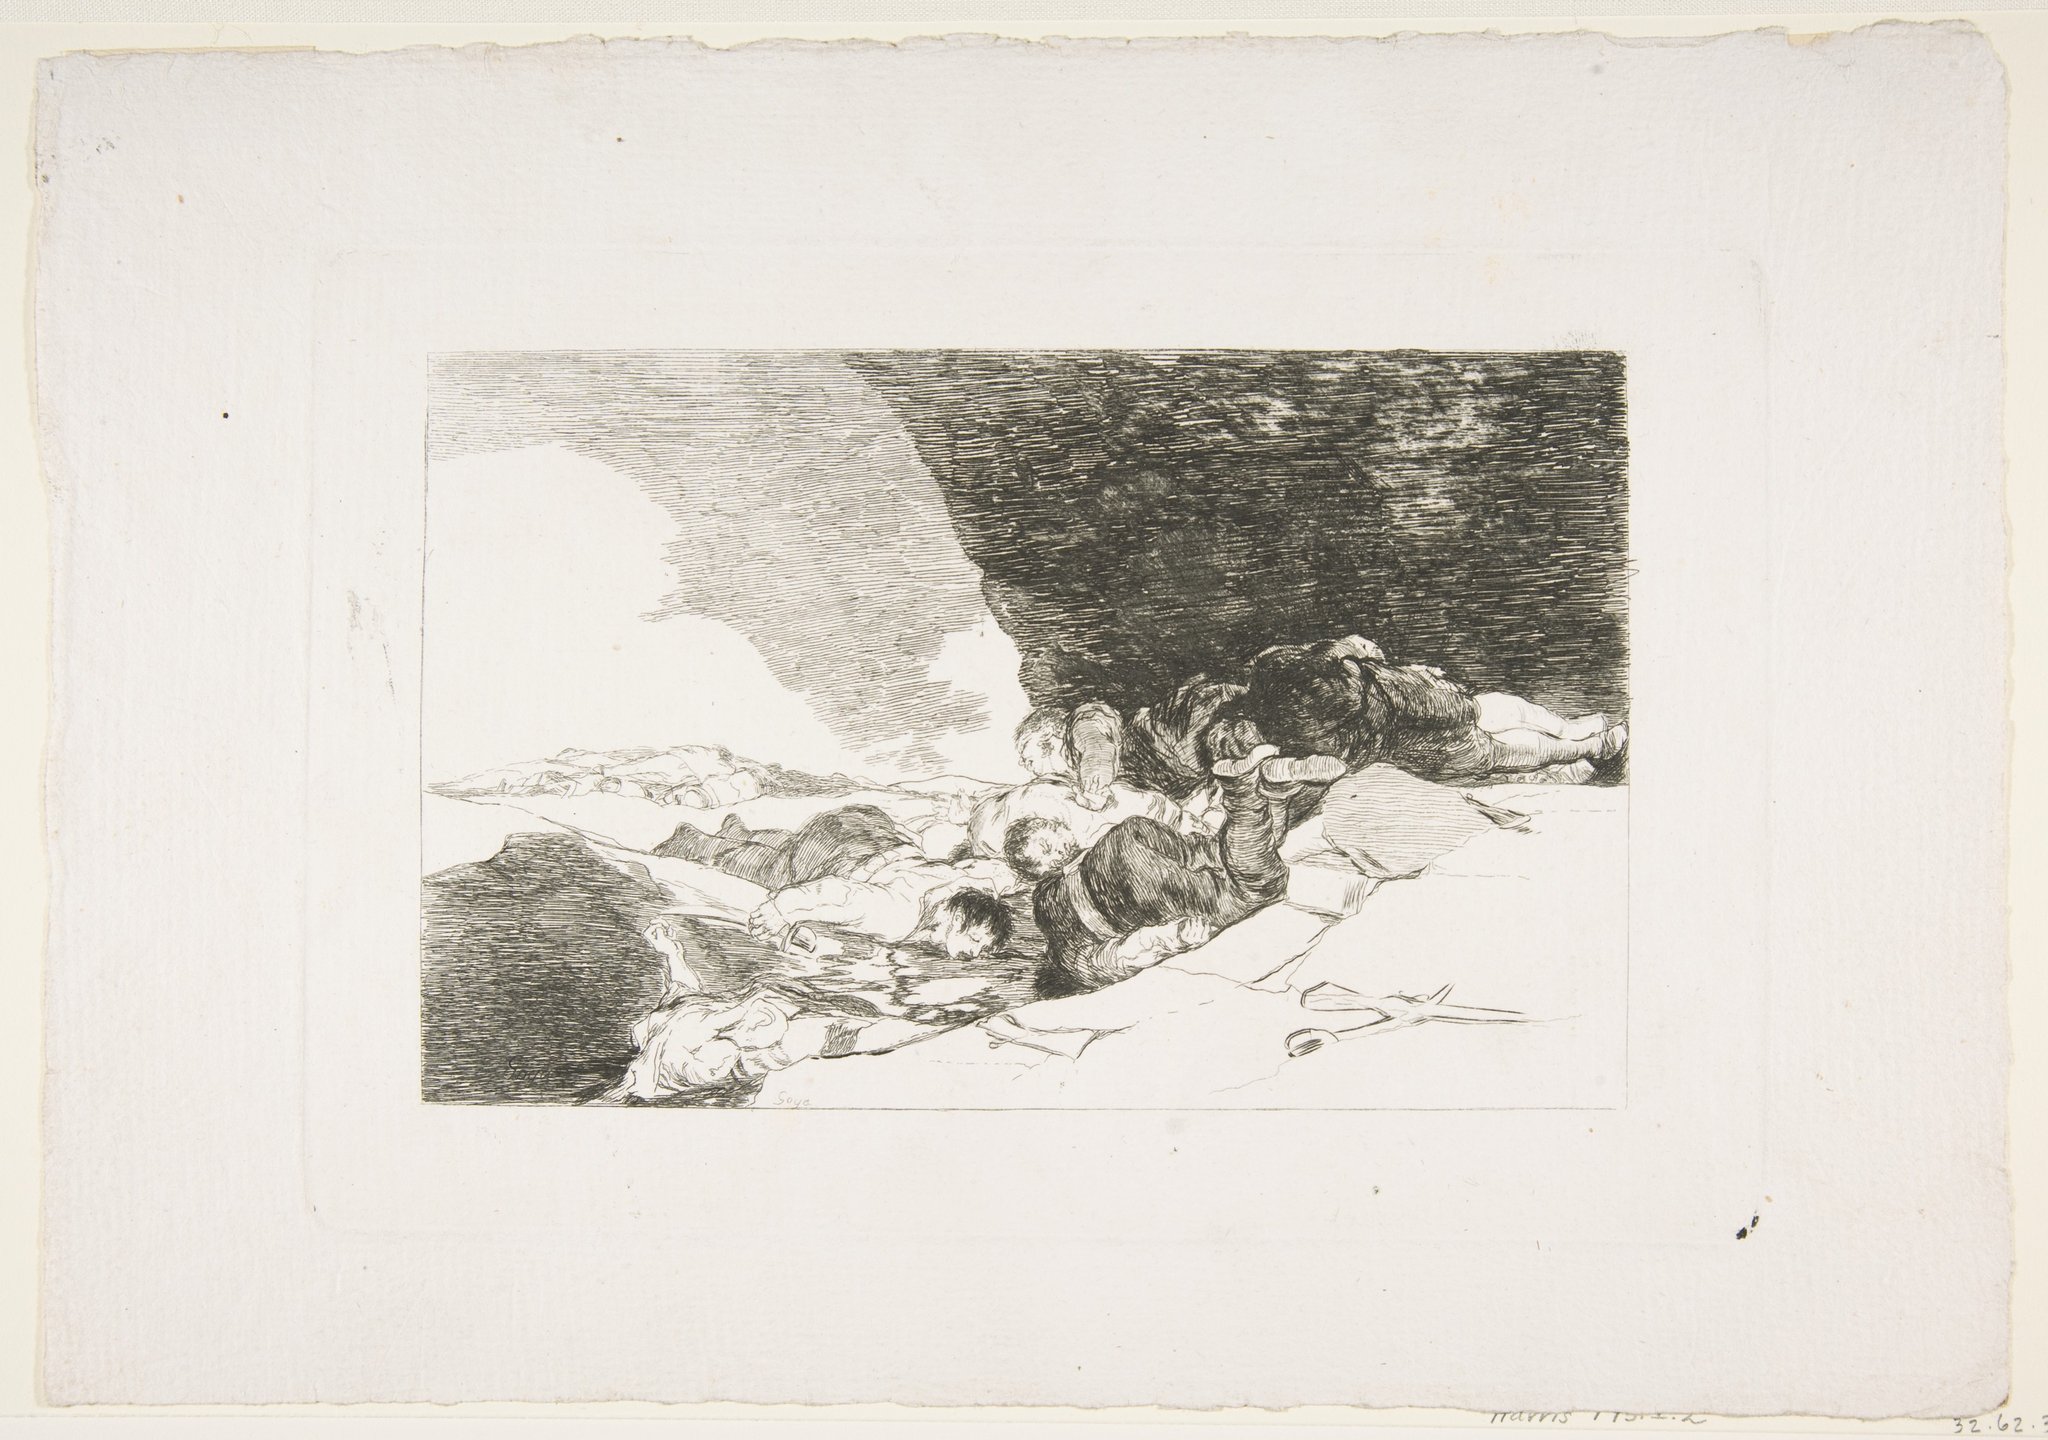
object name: print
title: Plate 23 from "The Disasters of War" (Los Desastres de la Guerra): 'The Same Elsewhere' (Lo mismo en otras partes)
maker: goya (francisco de goya y lucientes)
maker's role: artist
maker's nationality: spanish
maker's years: 1746-1828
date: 1810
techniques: engraving, drypoint, etching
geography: spain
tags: men,death